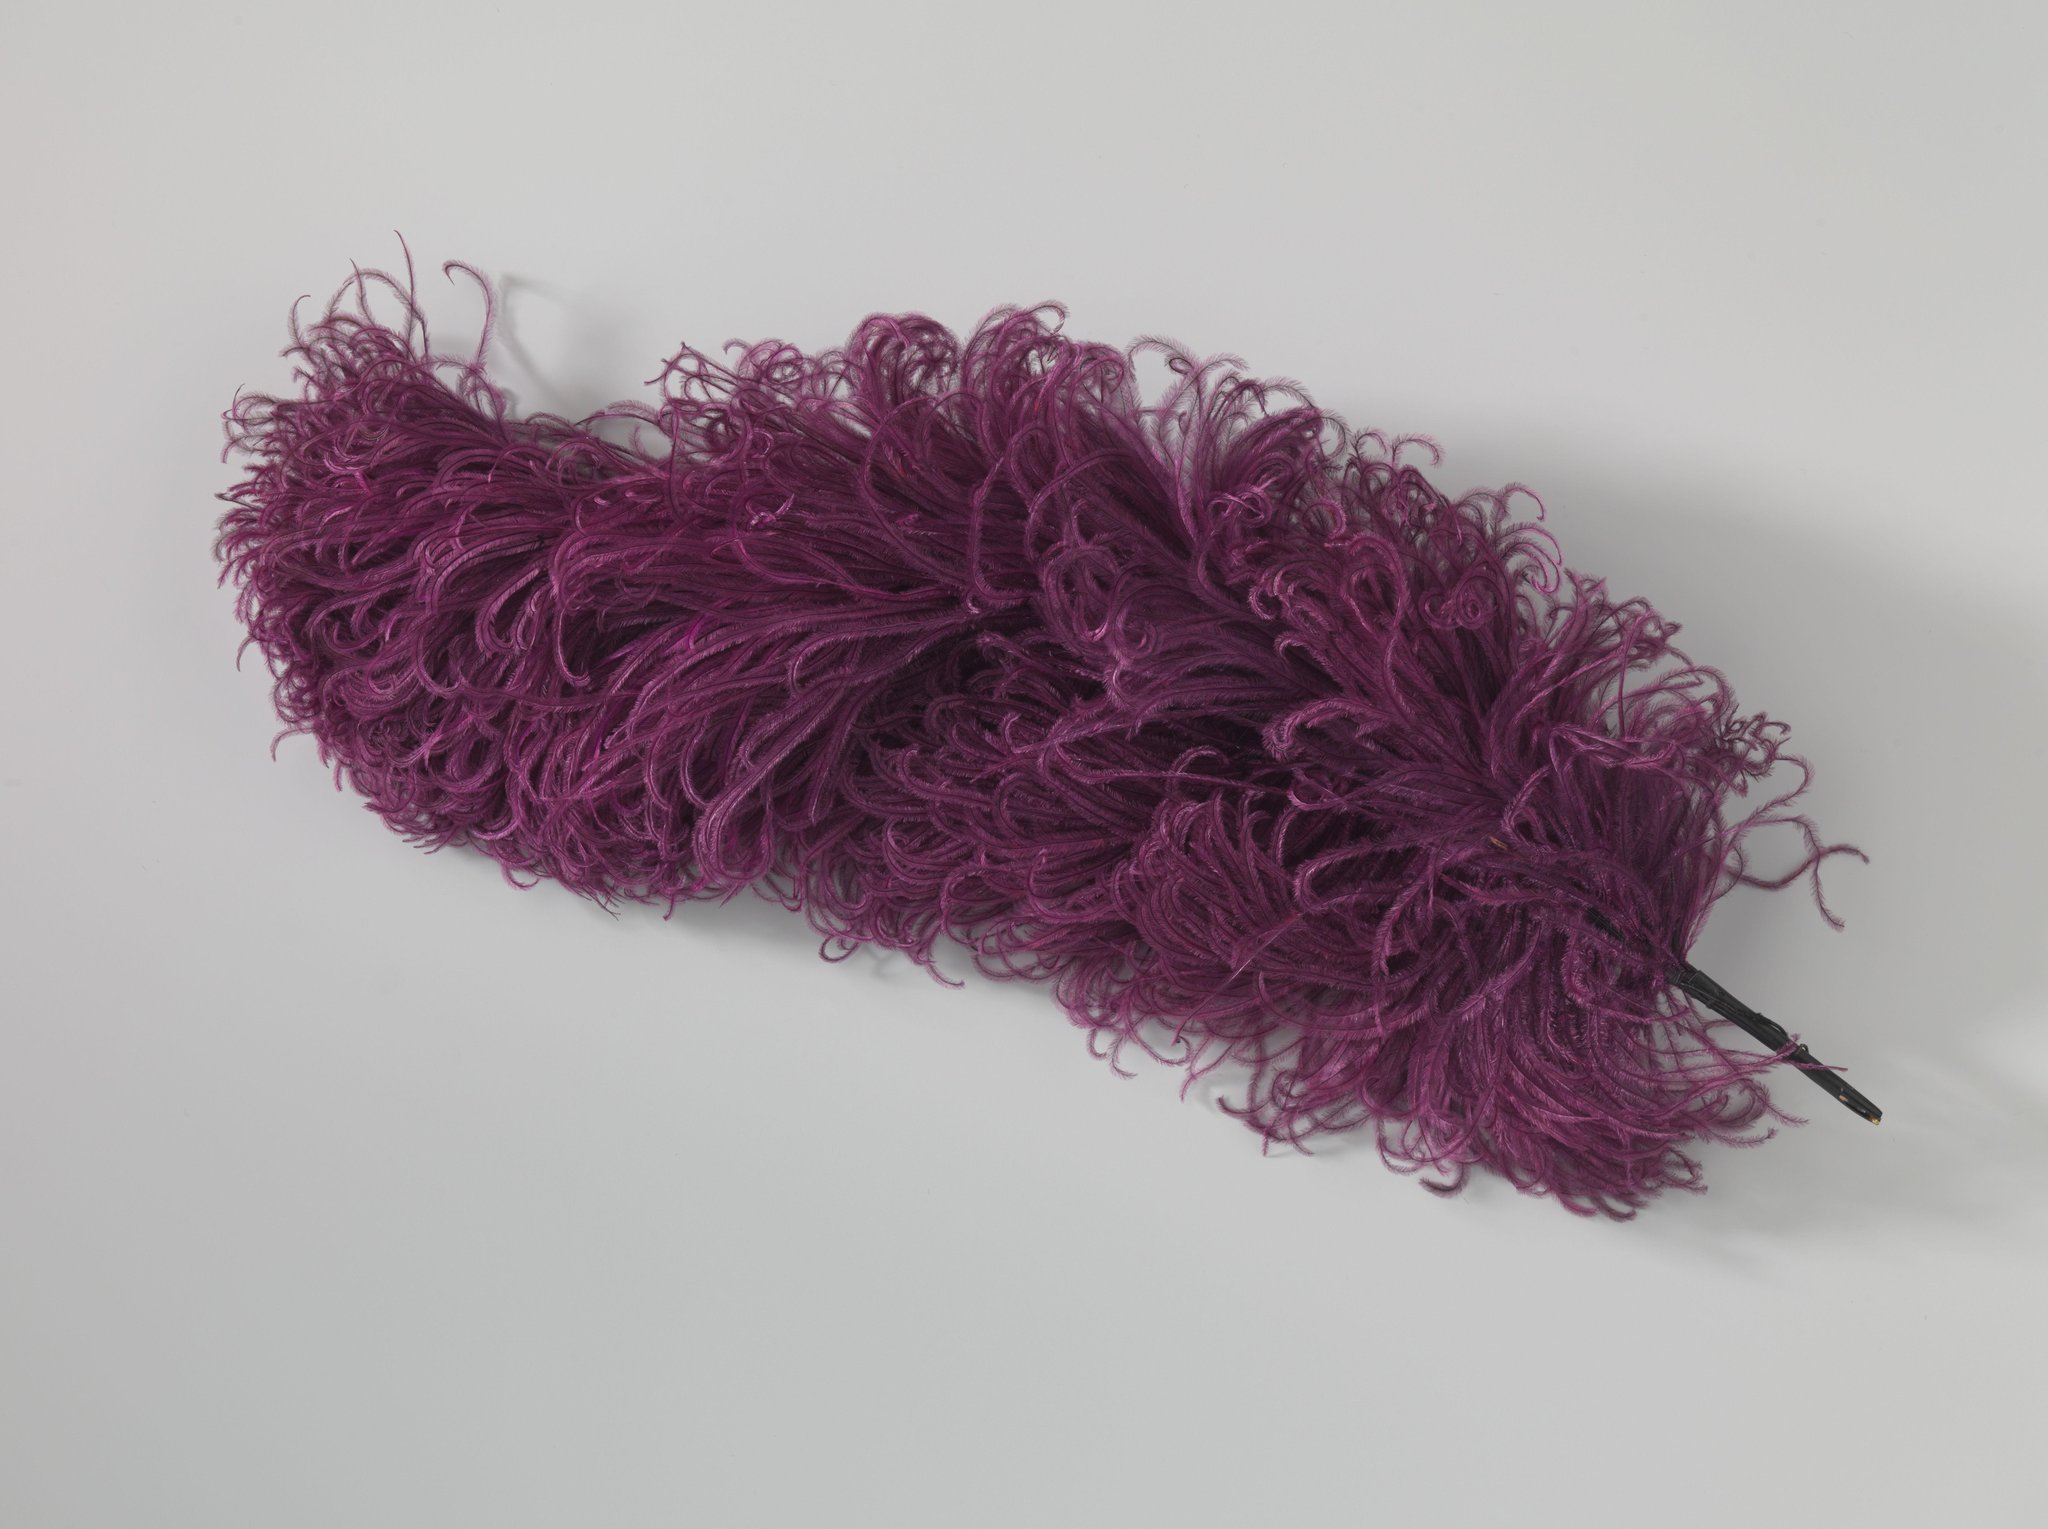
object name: womenswear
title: Struisveer, paars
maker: Anonymous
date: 1880-1940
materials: metal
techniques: painting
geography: western europe